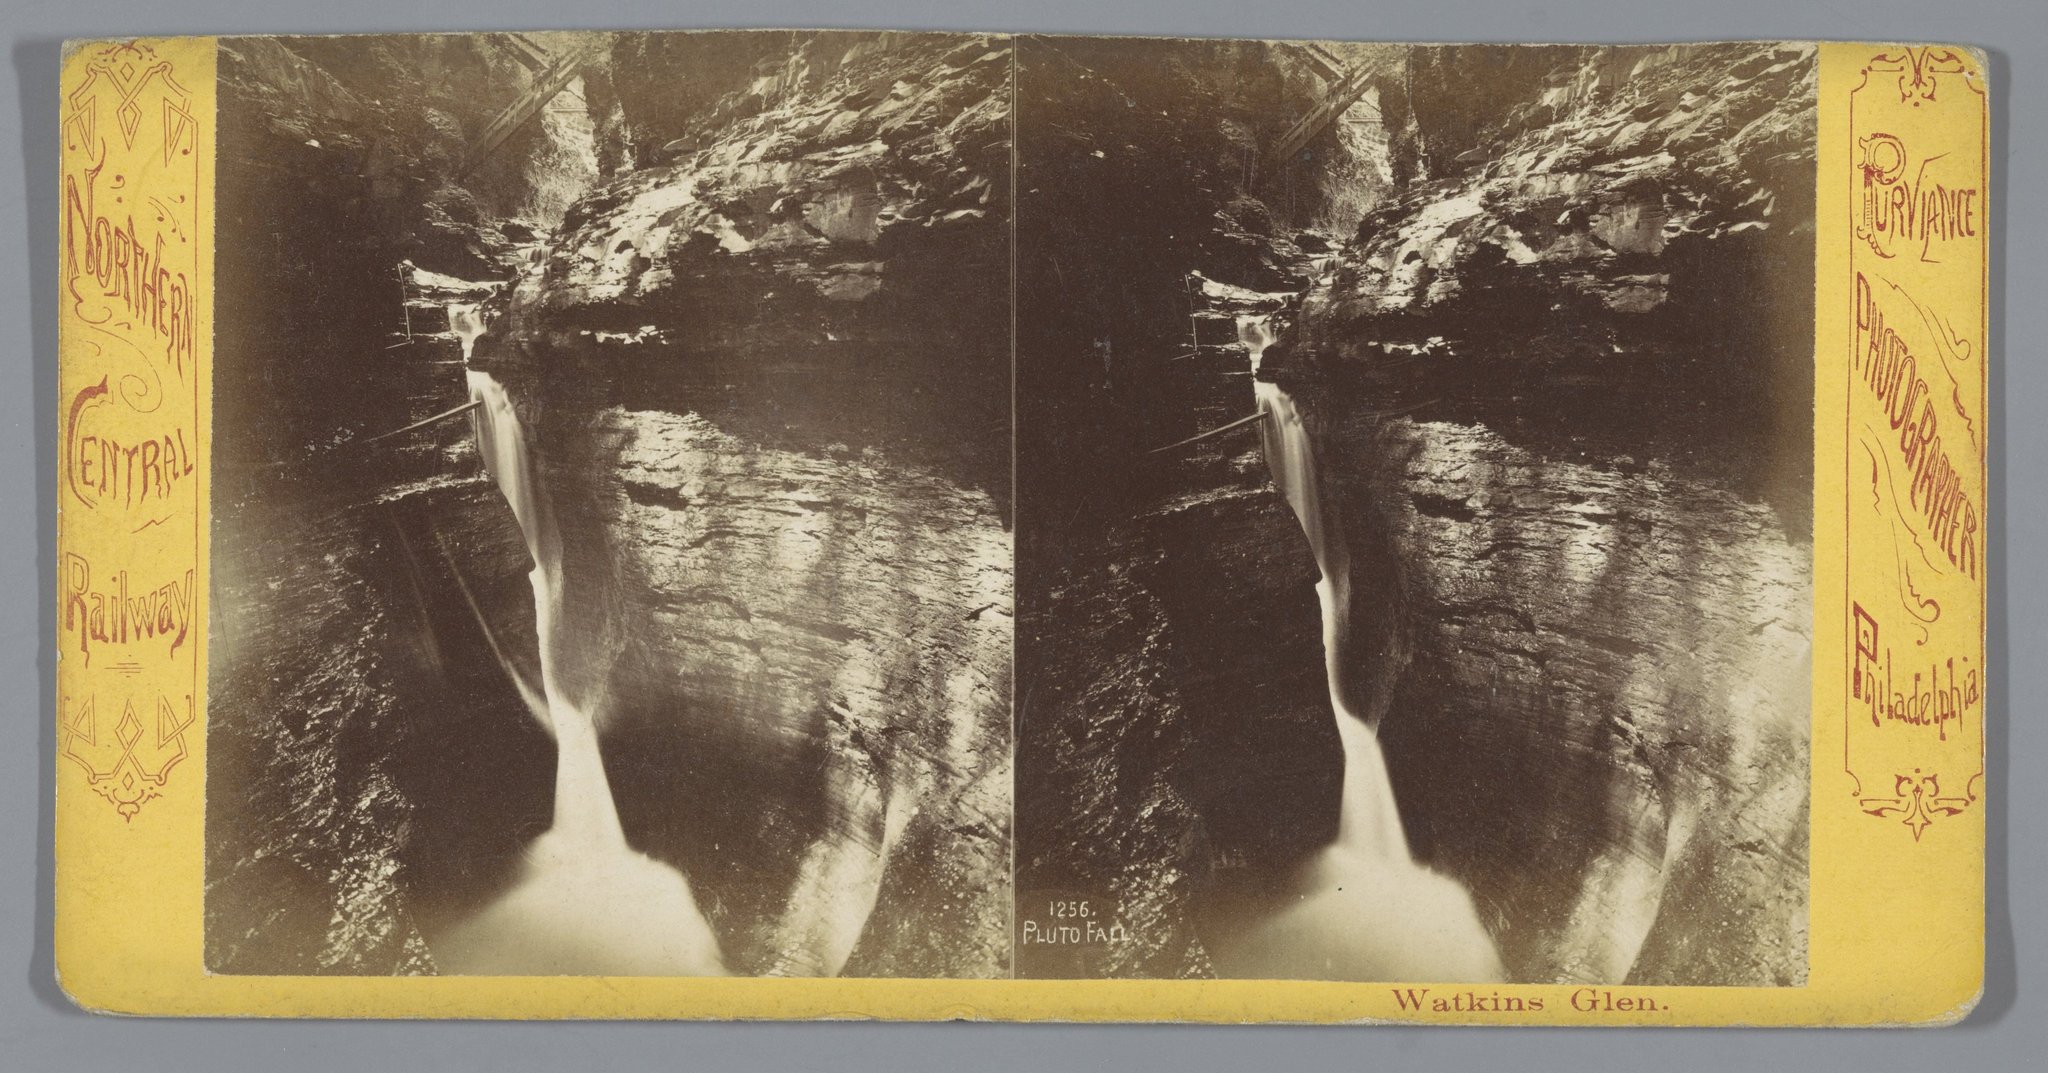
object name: stereograph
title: Watkins Glen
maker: william t. purviance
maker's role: publisher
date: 1860-1880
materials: cardboard, paper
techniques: albumen print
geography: watkins glen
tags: waterfall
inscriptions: title: ‘Pluto fall.’, number: ‘1256’